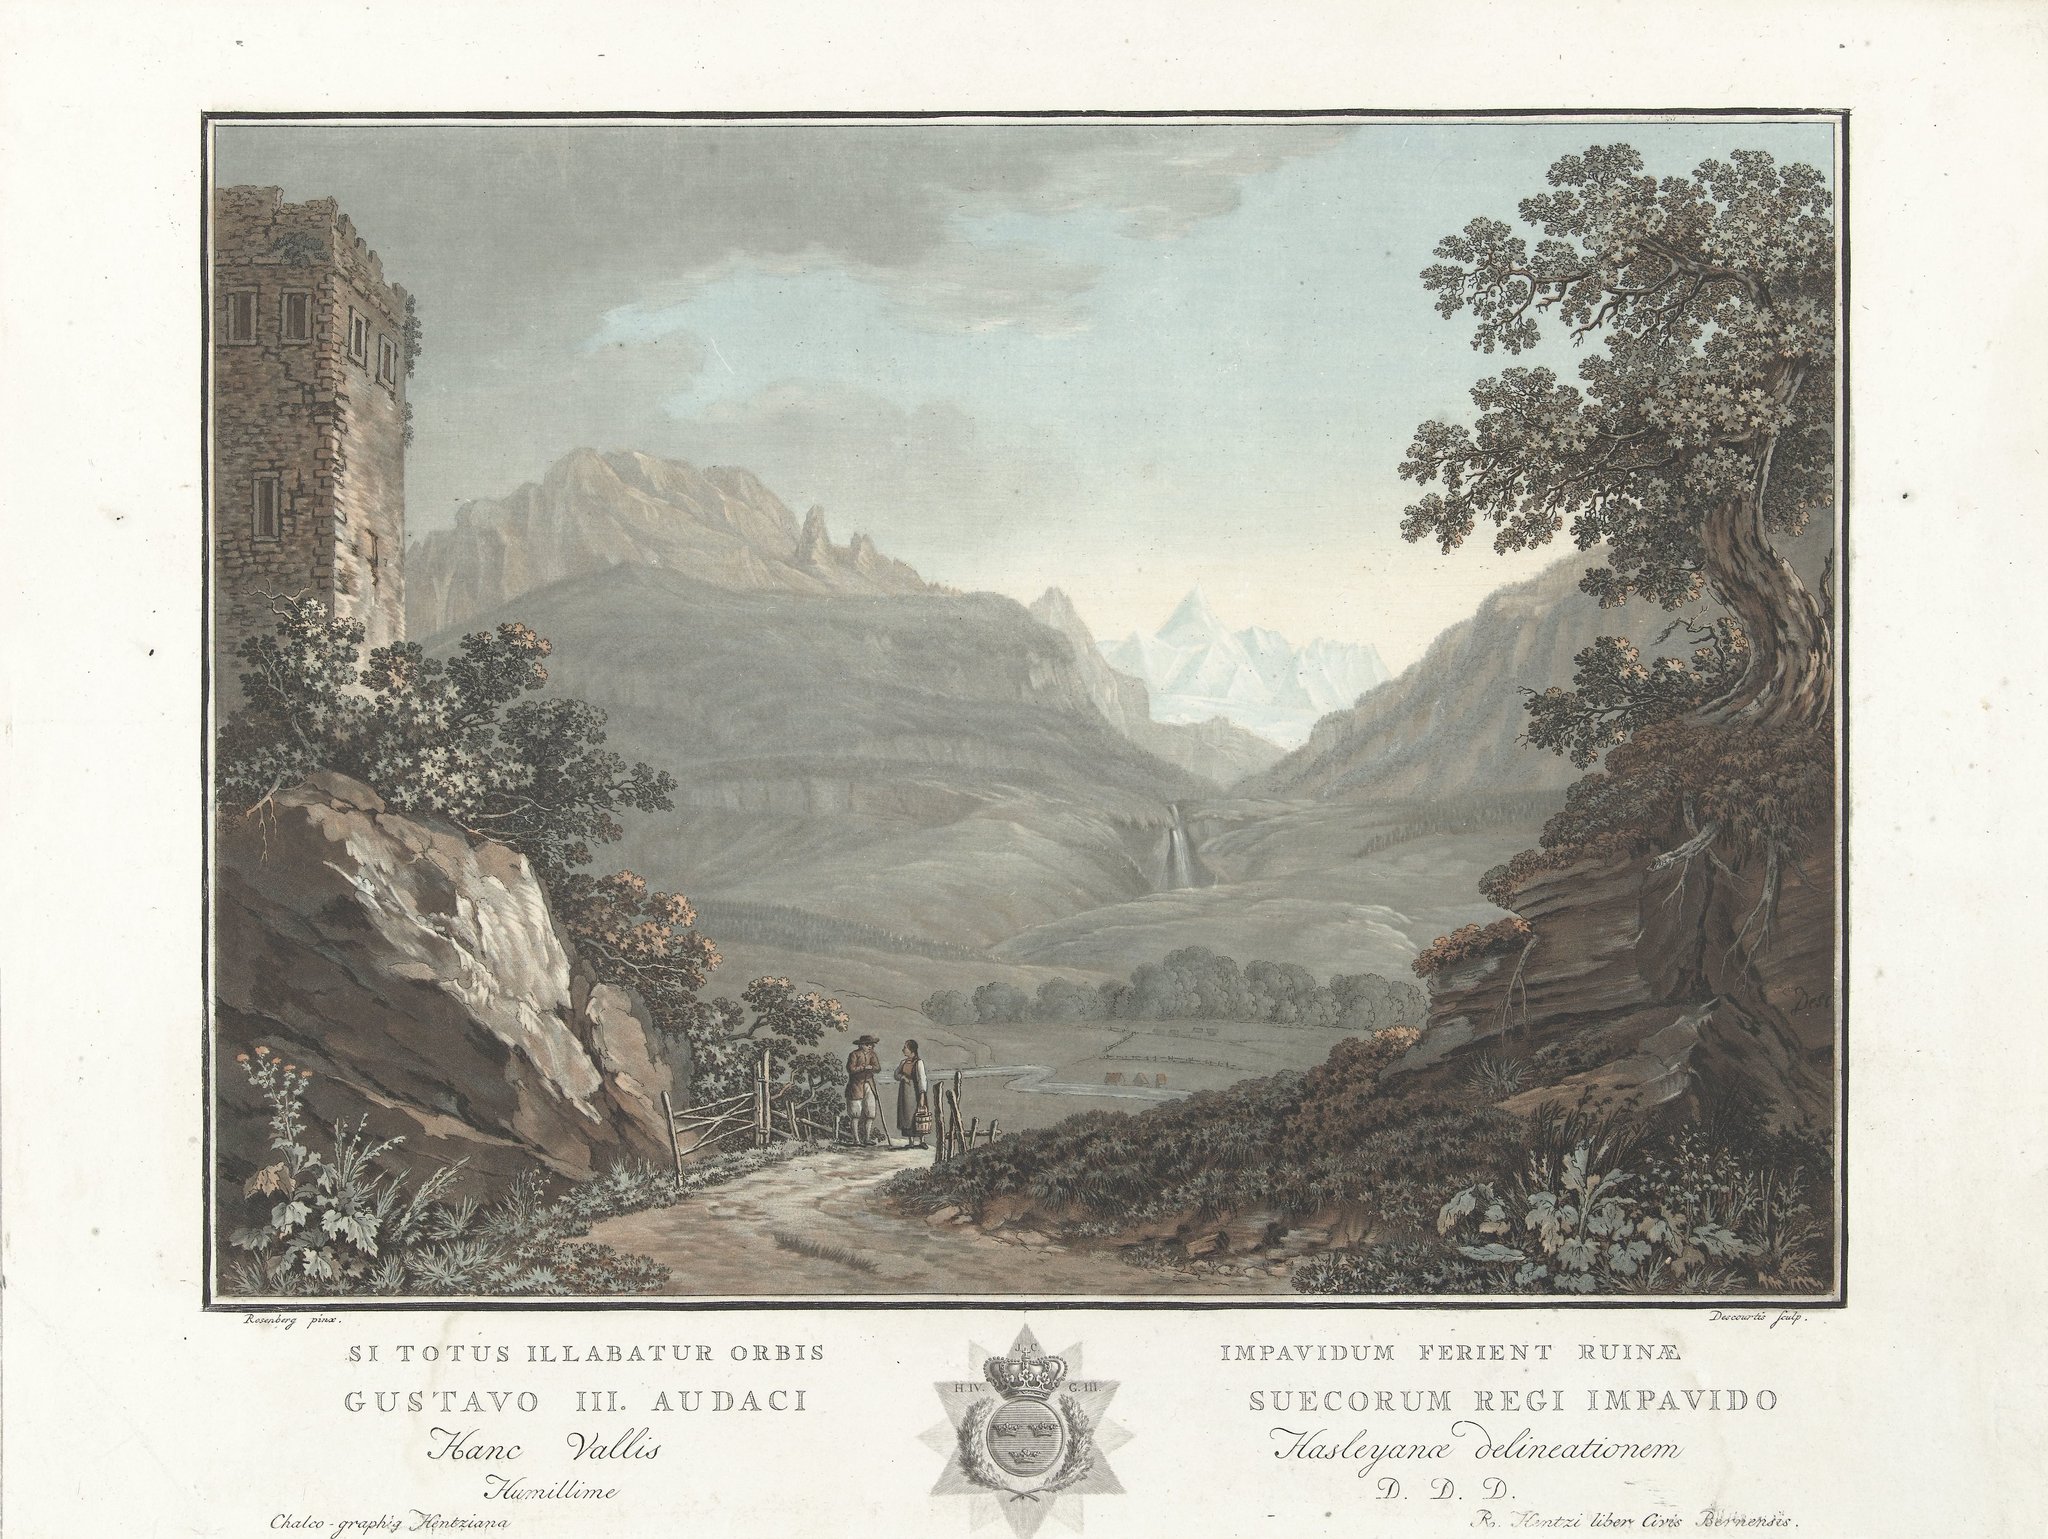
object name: print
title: Vues remarquables des montagnes de la Suisse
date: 1763-1785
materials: paper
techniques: etching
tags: mountains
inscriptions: inscription: ‘R. Hentzi liber Civis Bernensis’, inscription: ‘chalco-graphig Hentziana’, inscription: ‘Si totus illabatur orbis impavidum ferient ruinae Gustavo III audaci suecorum regi impavido hanc Vallis Hasleyanae delineatorum humillime D.D.D.’, collector's mark: Lugt 2760, collector's mark: Lugt 2228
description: Een berglandschap in Zwitserland. Tussen twee rotsen een pad met een man en een vrouw. Onder de voorstelling tekst en een wapenschild.